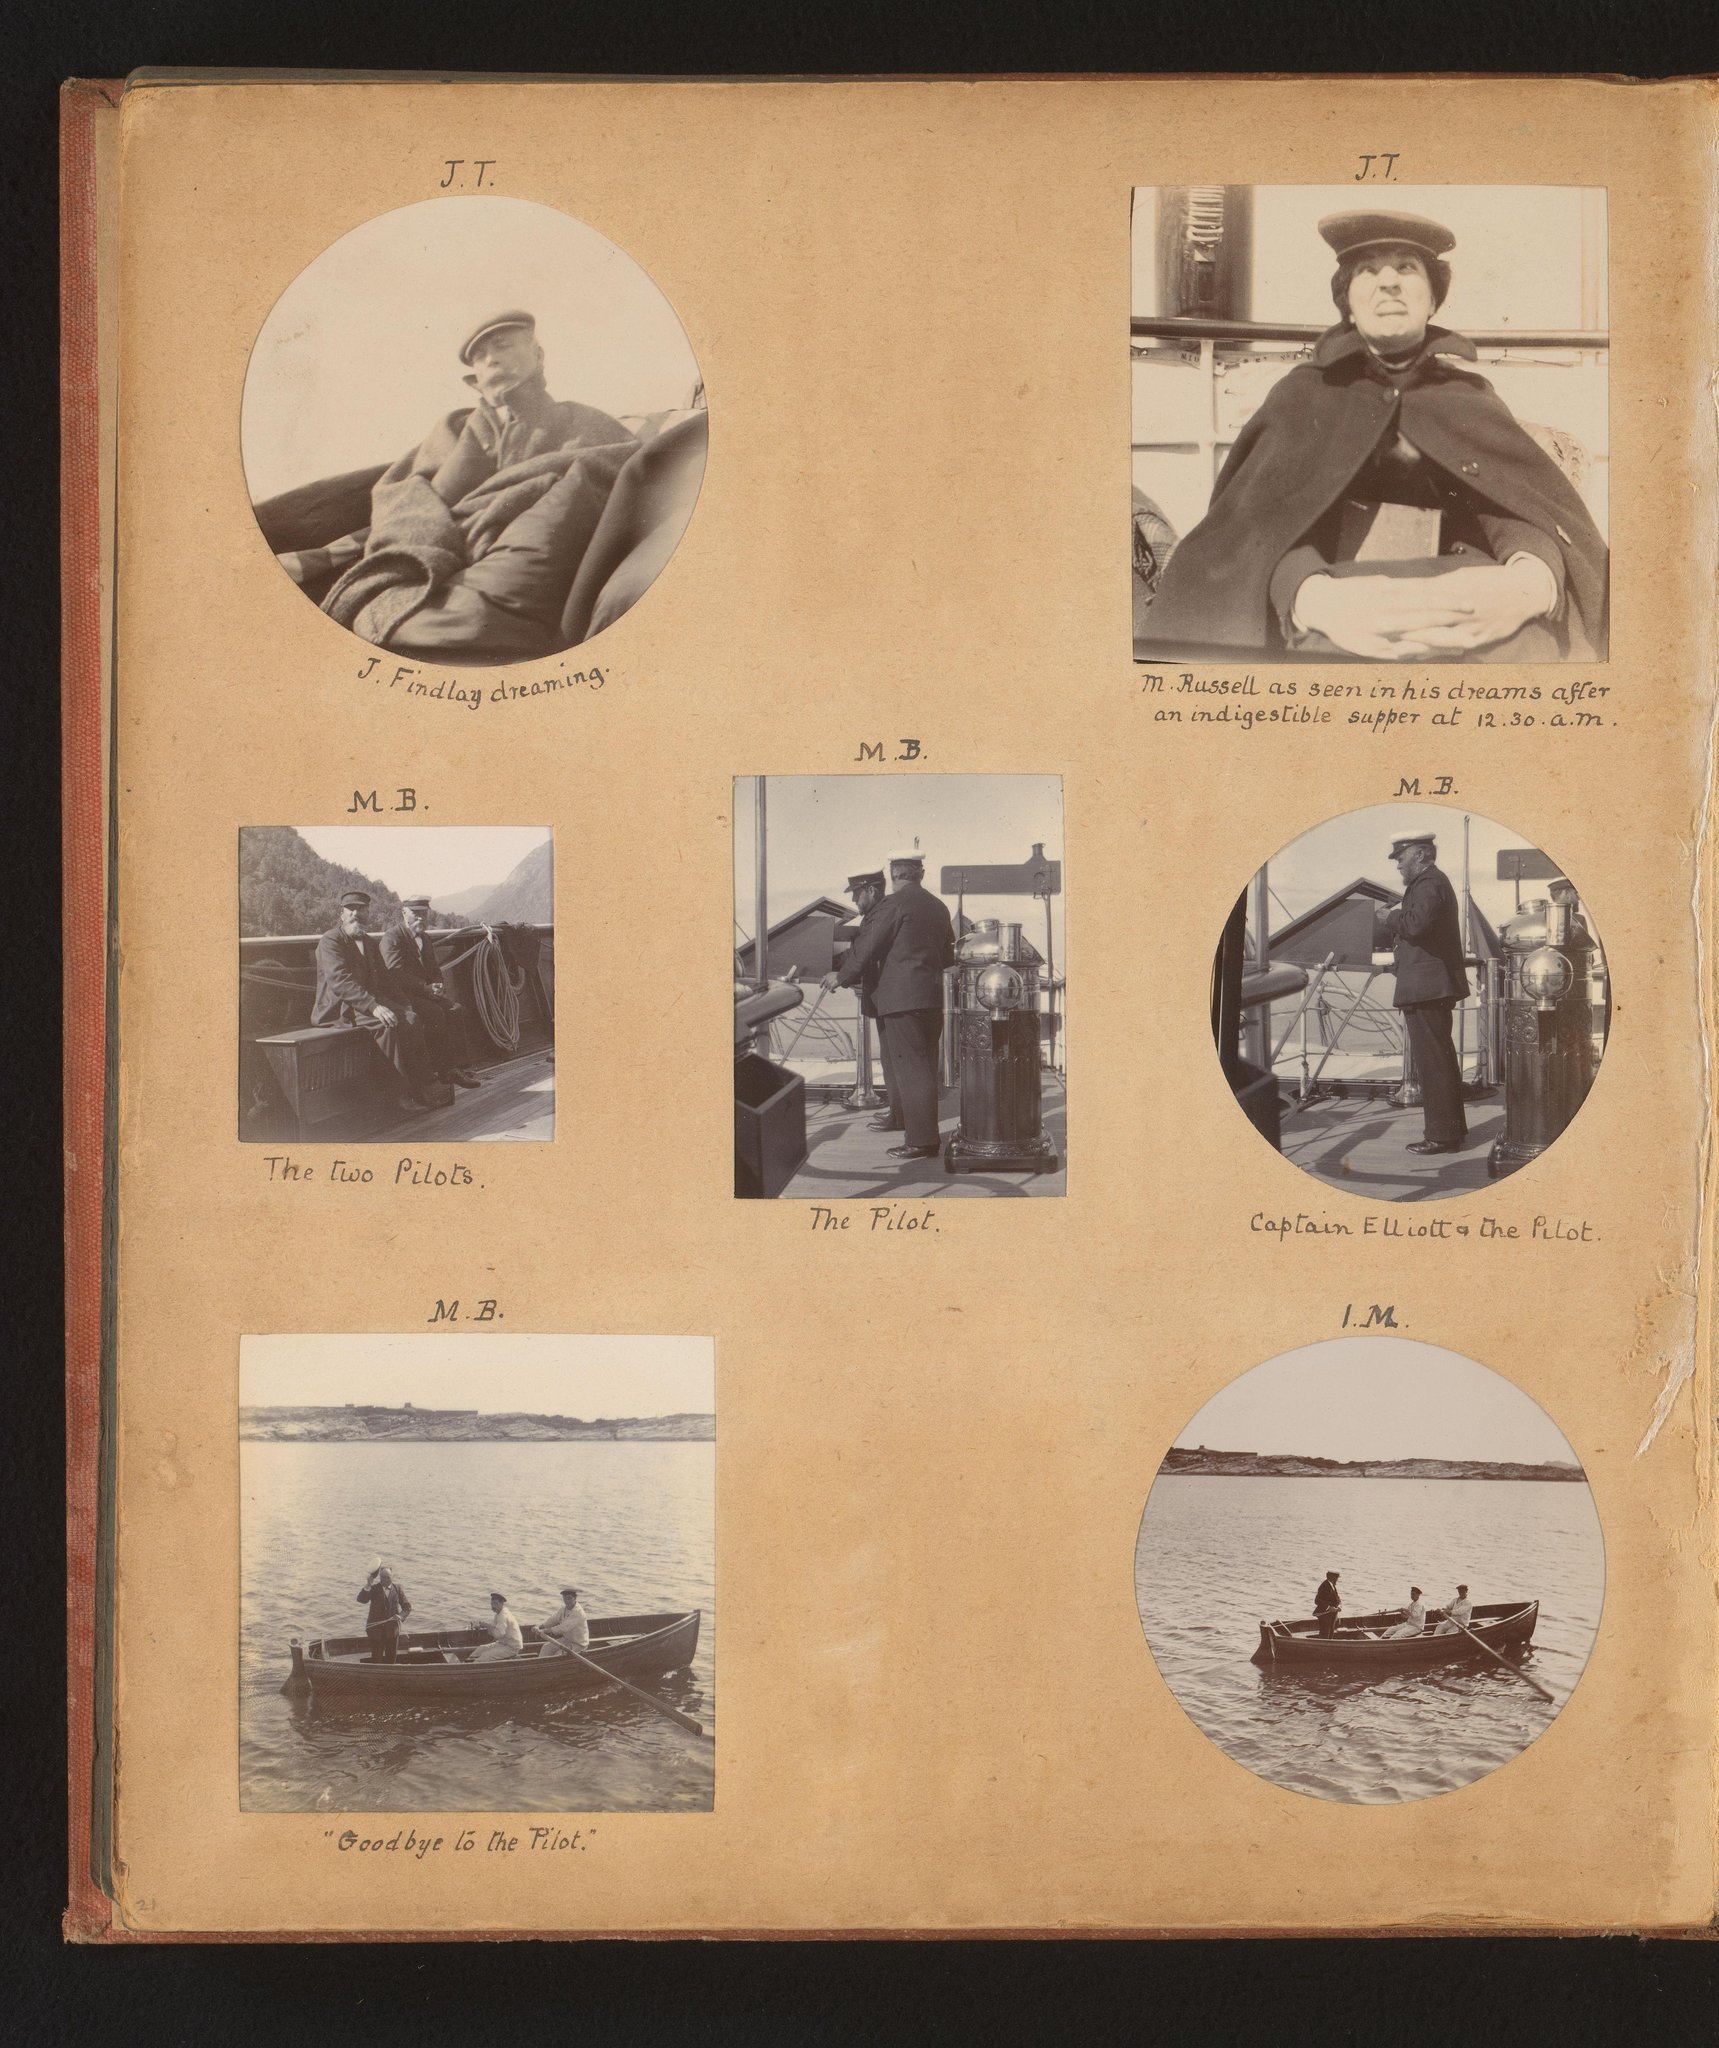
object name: album leaf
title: Zeven foto's van het reisgezelschap en de bemanning van de S.Y. Sapphire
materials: paper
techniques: gelatin silver print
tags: mary russell, crew ~ ship, sleeping in chair, rowing facing backward, pulling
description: Deze foto's maken deel uit van een album.